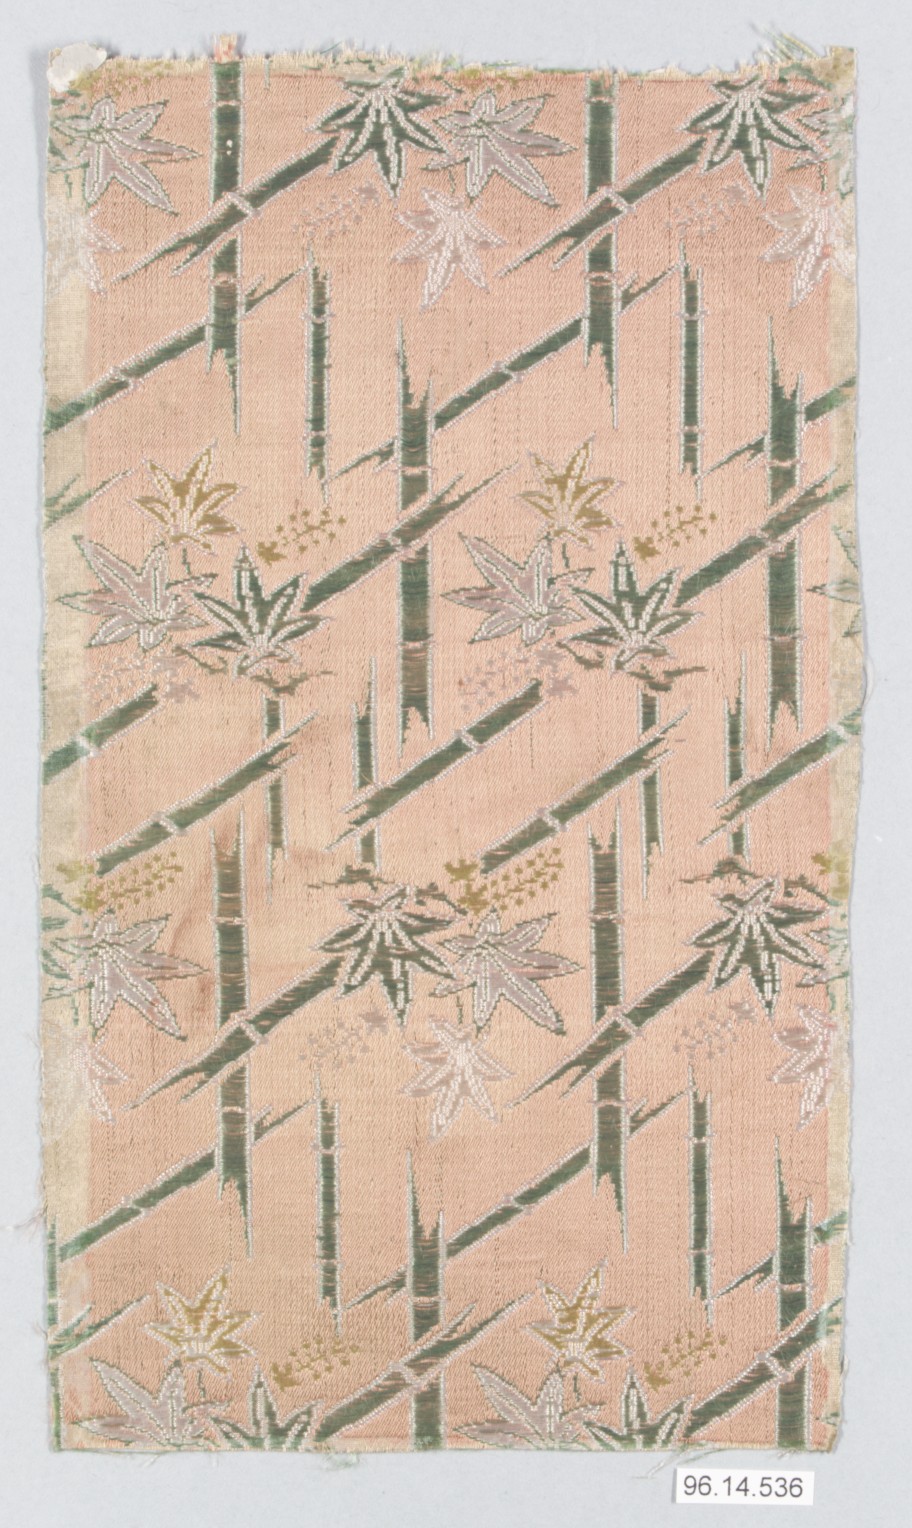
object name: piece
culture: japanese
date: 1701-1900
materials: silk